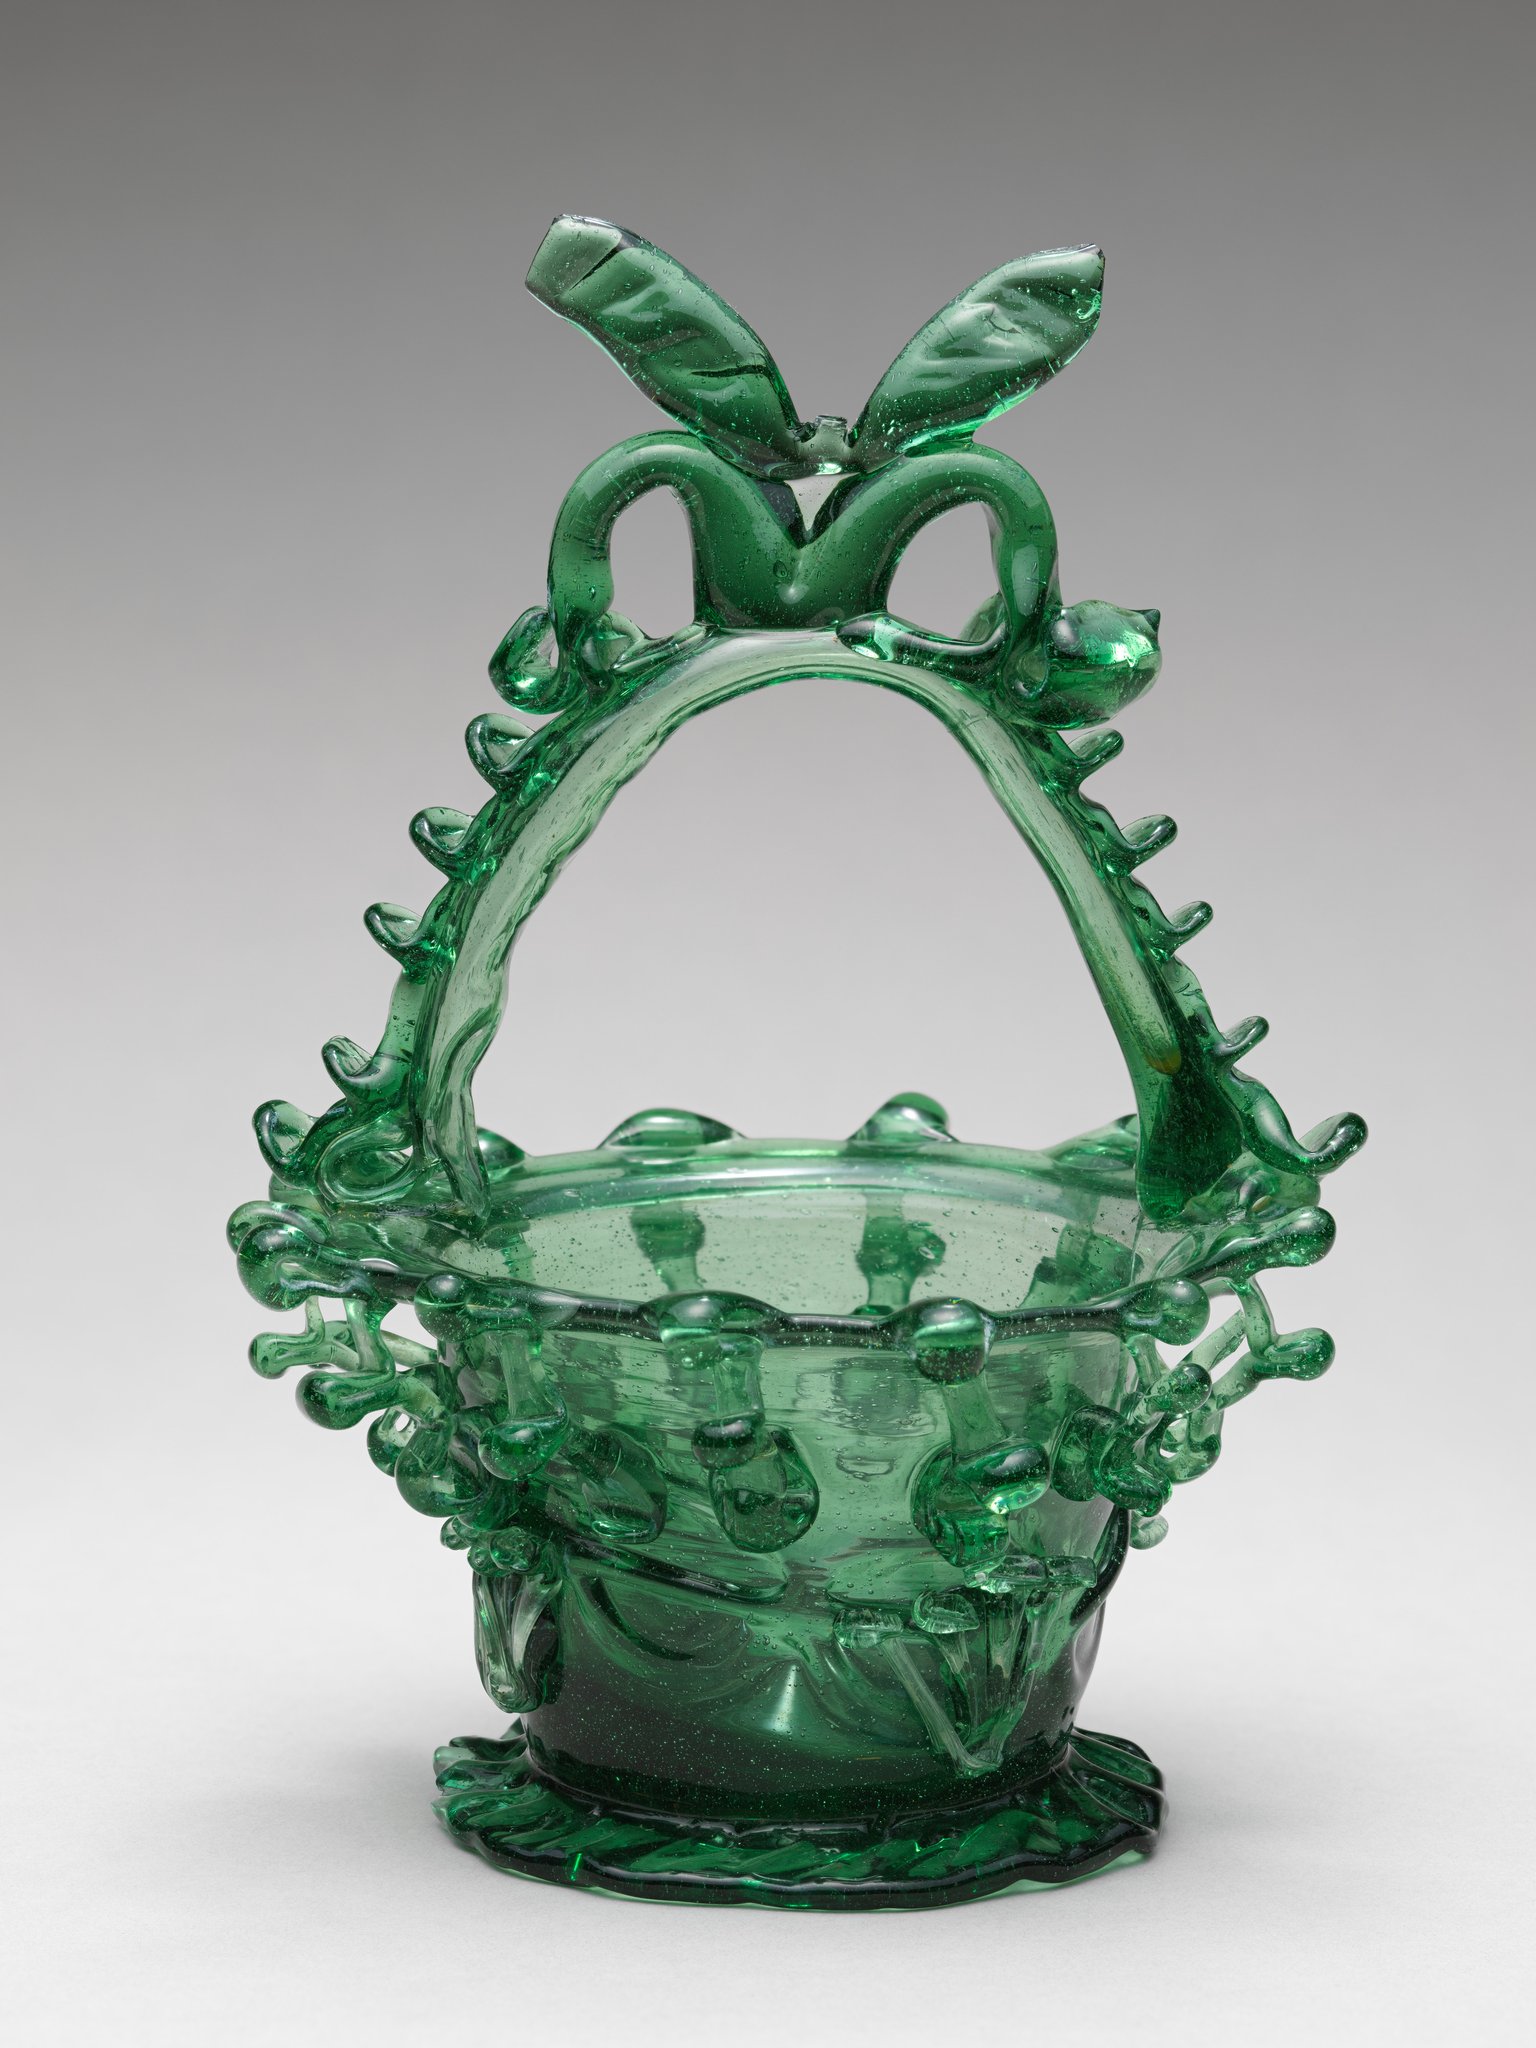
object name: basket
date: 1601-1700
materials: glass